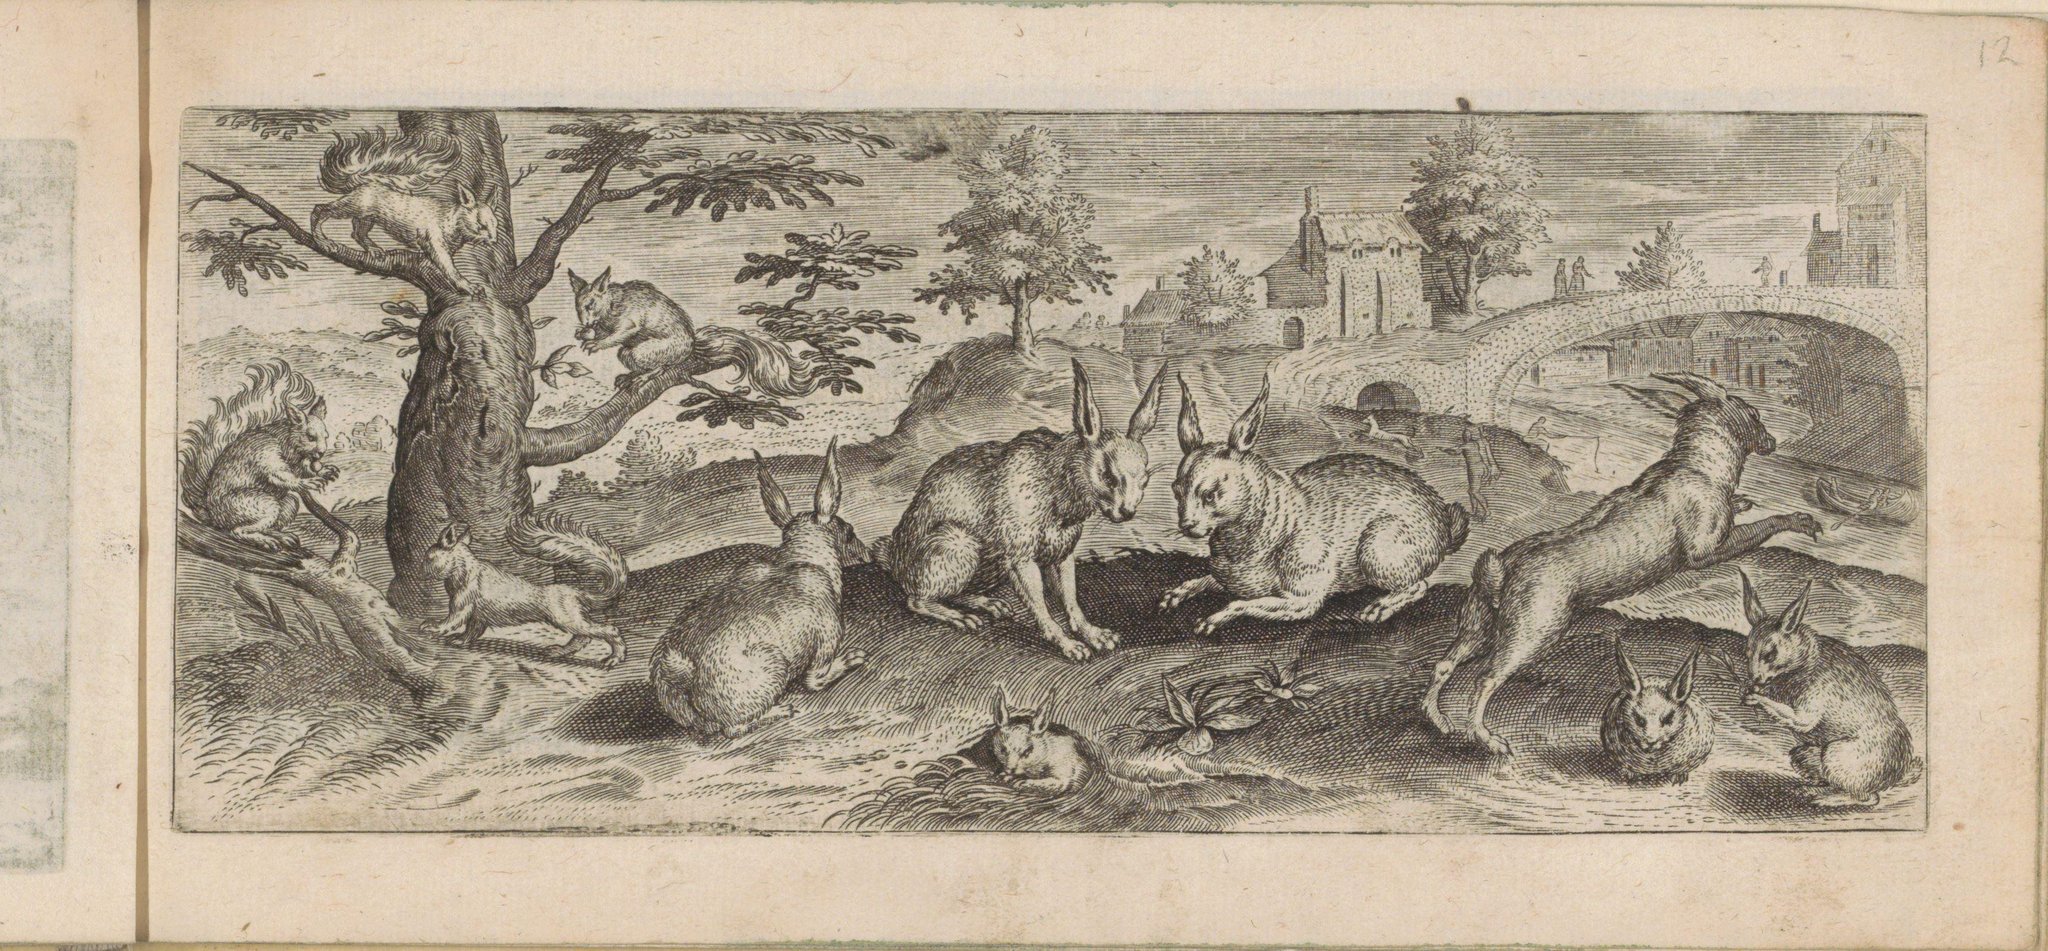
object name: print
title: Animalium Quadrupedum Omnis Generis Verae et Artificiosissimae Delineationes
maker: eduwart van hoeswinckel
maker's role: publisher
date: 1583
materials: paper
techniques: engraving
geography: antwerp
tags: landscapes in the temperate zone, landscape with bridge, viaduct or aqueduct, rodents: squirrel, rodents: rabbit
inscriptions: collector's mark: Lugt 2760, collector's mark: Lugt 2228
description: Links vier eekhoorns in en bij een boom. Op de voorgrond konijnen. Op de achtergrond een rivier met brug. Aan het water een hengelaar. Deze prent maakt deel uit van een album.